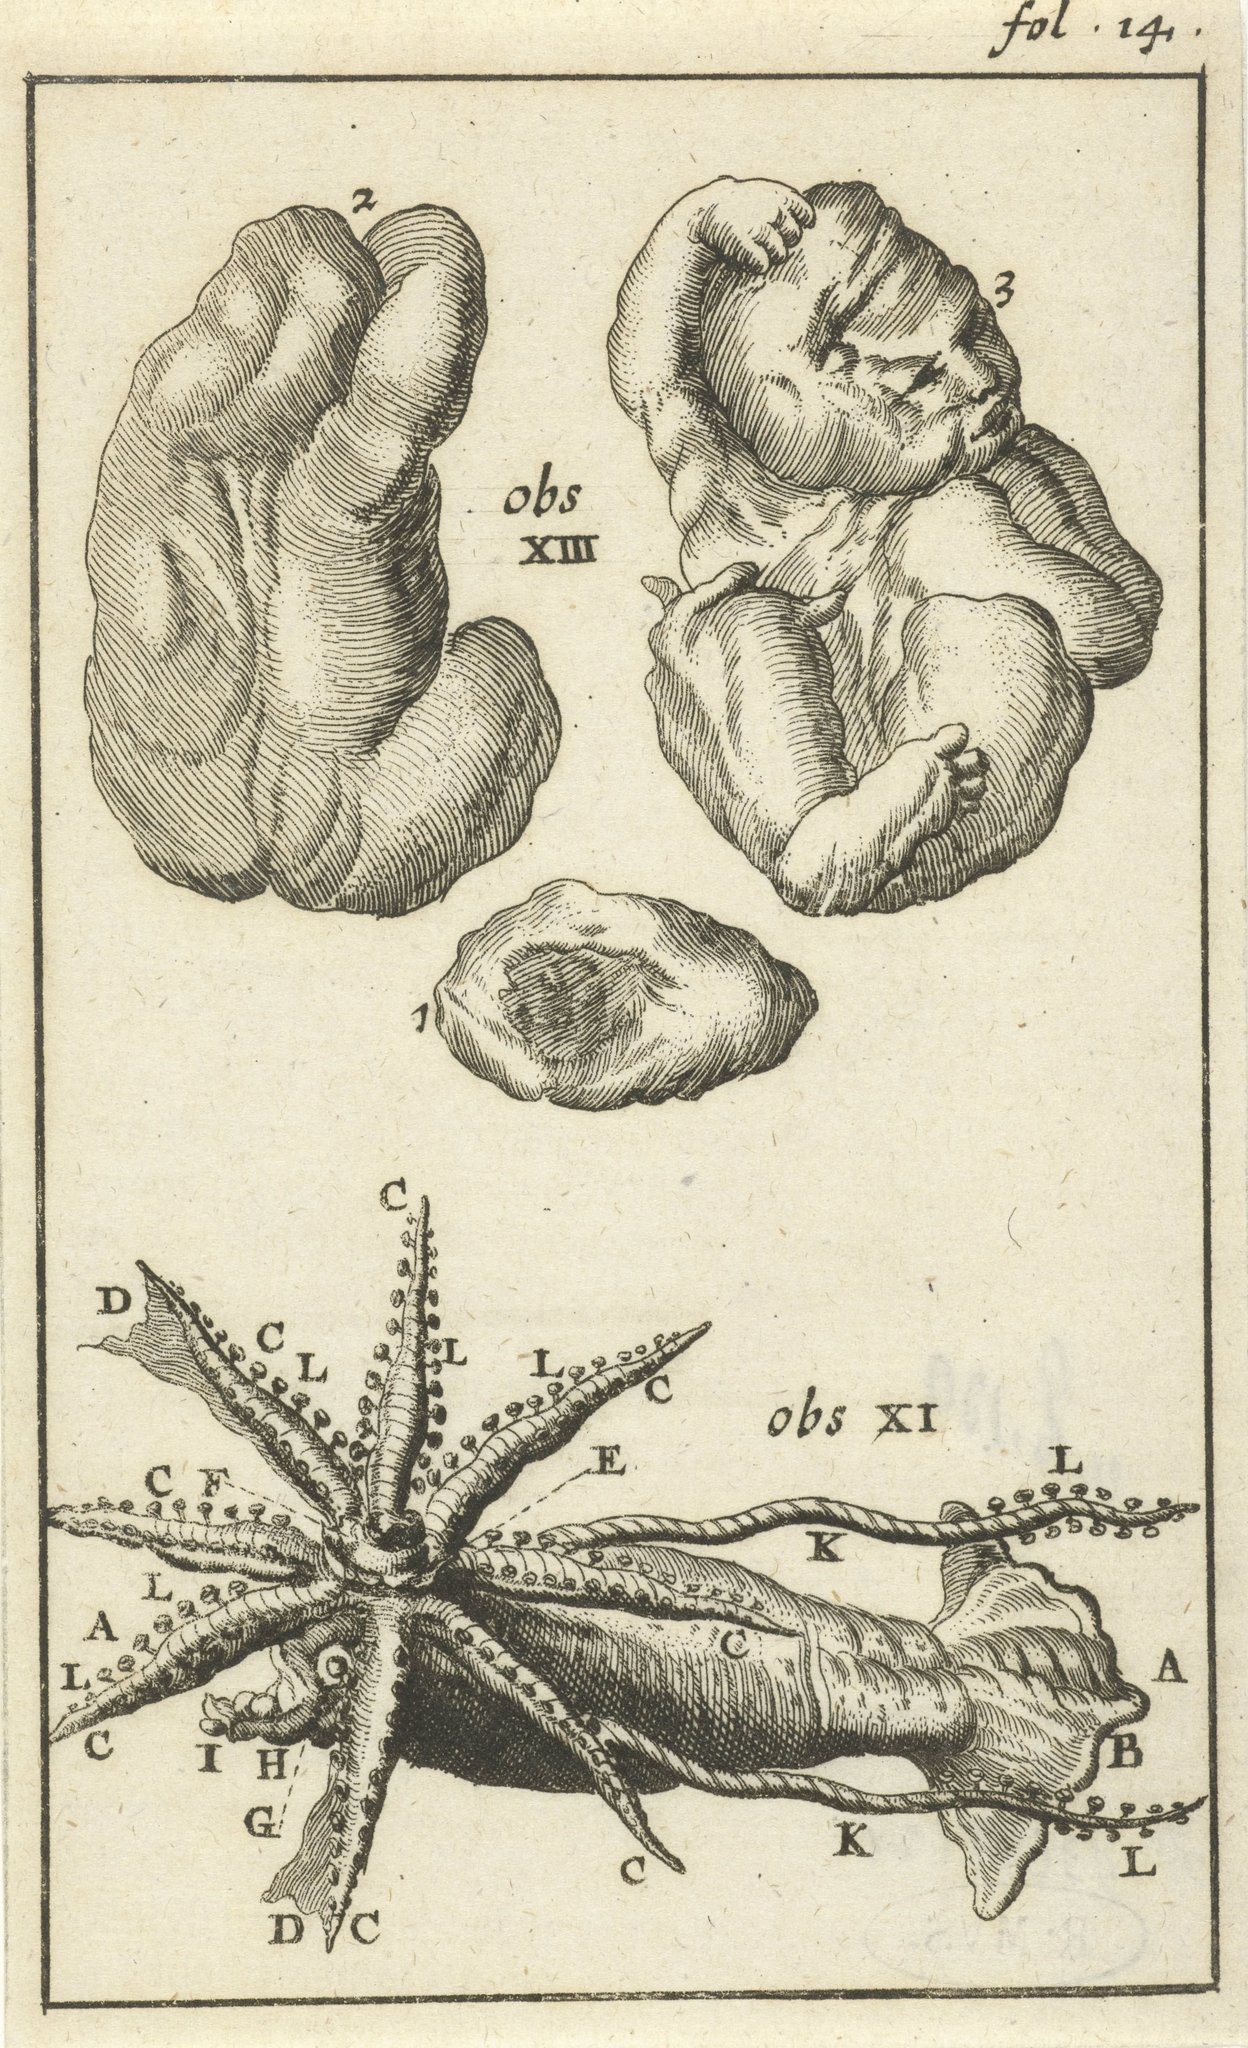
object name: book illustration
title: Anatomische afbeelding I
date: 1680-1688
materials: paper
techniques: etching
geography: amsterdam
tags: biology, anatomical models (usually series of five figures)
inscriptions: collector's mark: Lugt 2228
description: Illustratie opgenomen in: Blankaart, Steven. Collectanea medico-physica, oft Hollands jaar-register der genees- en natuur-kundige aanmerkingen, 3 delen, dl. I, fol. 14. Amsterdam: Jan Claesz ten Hoorn, 1680-1688.